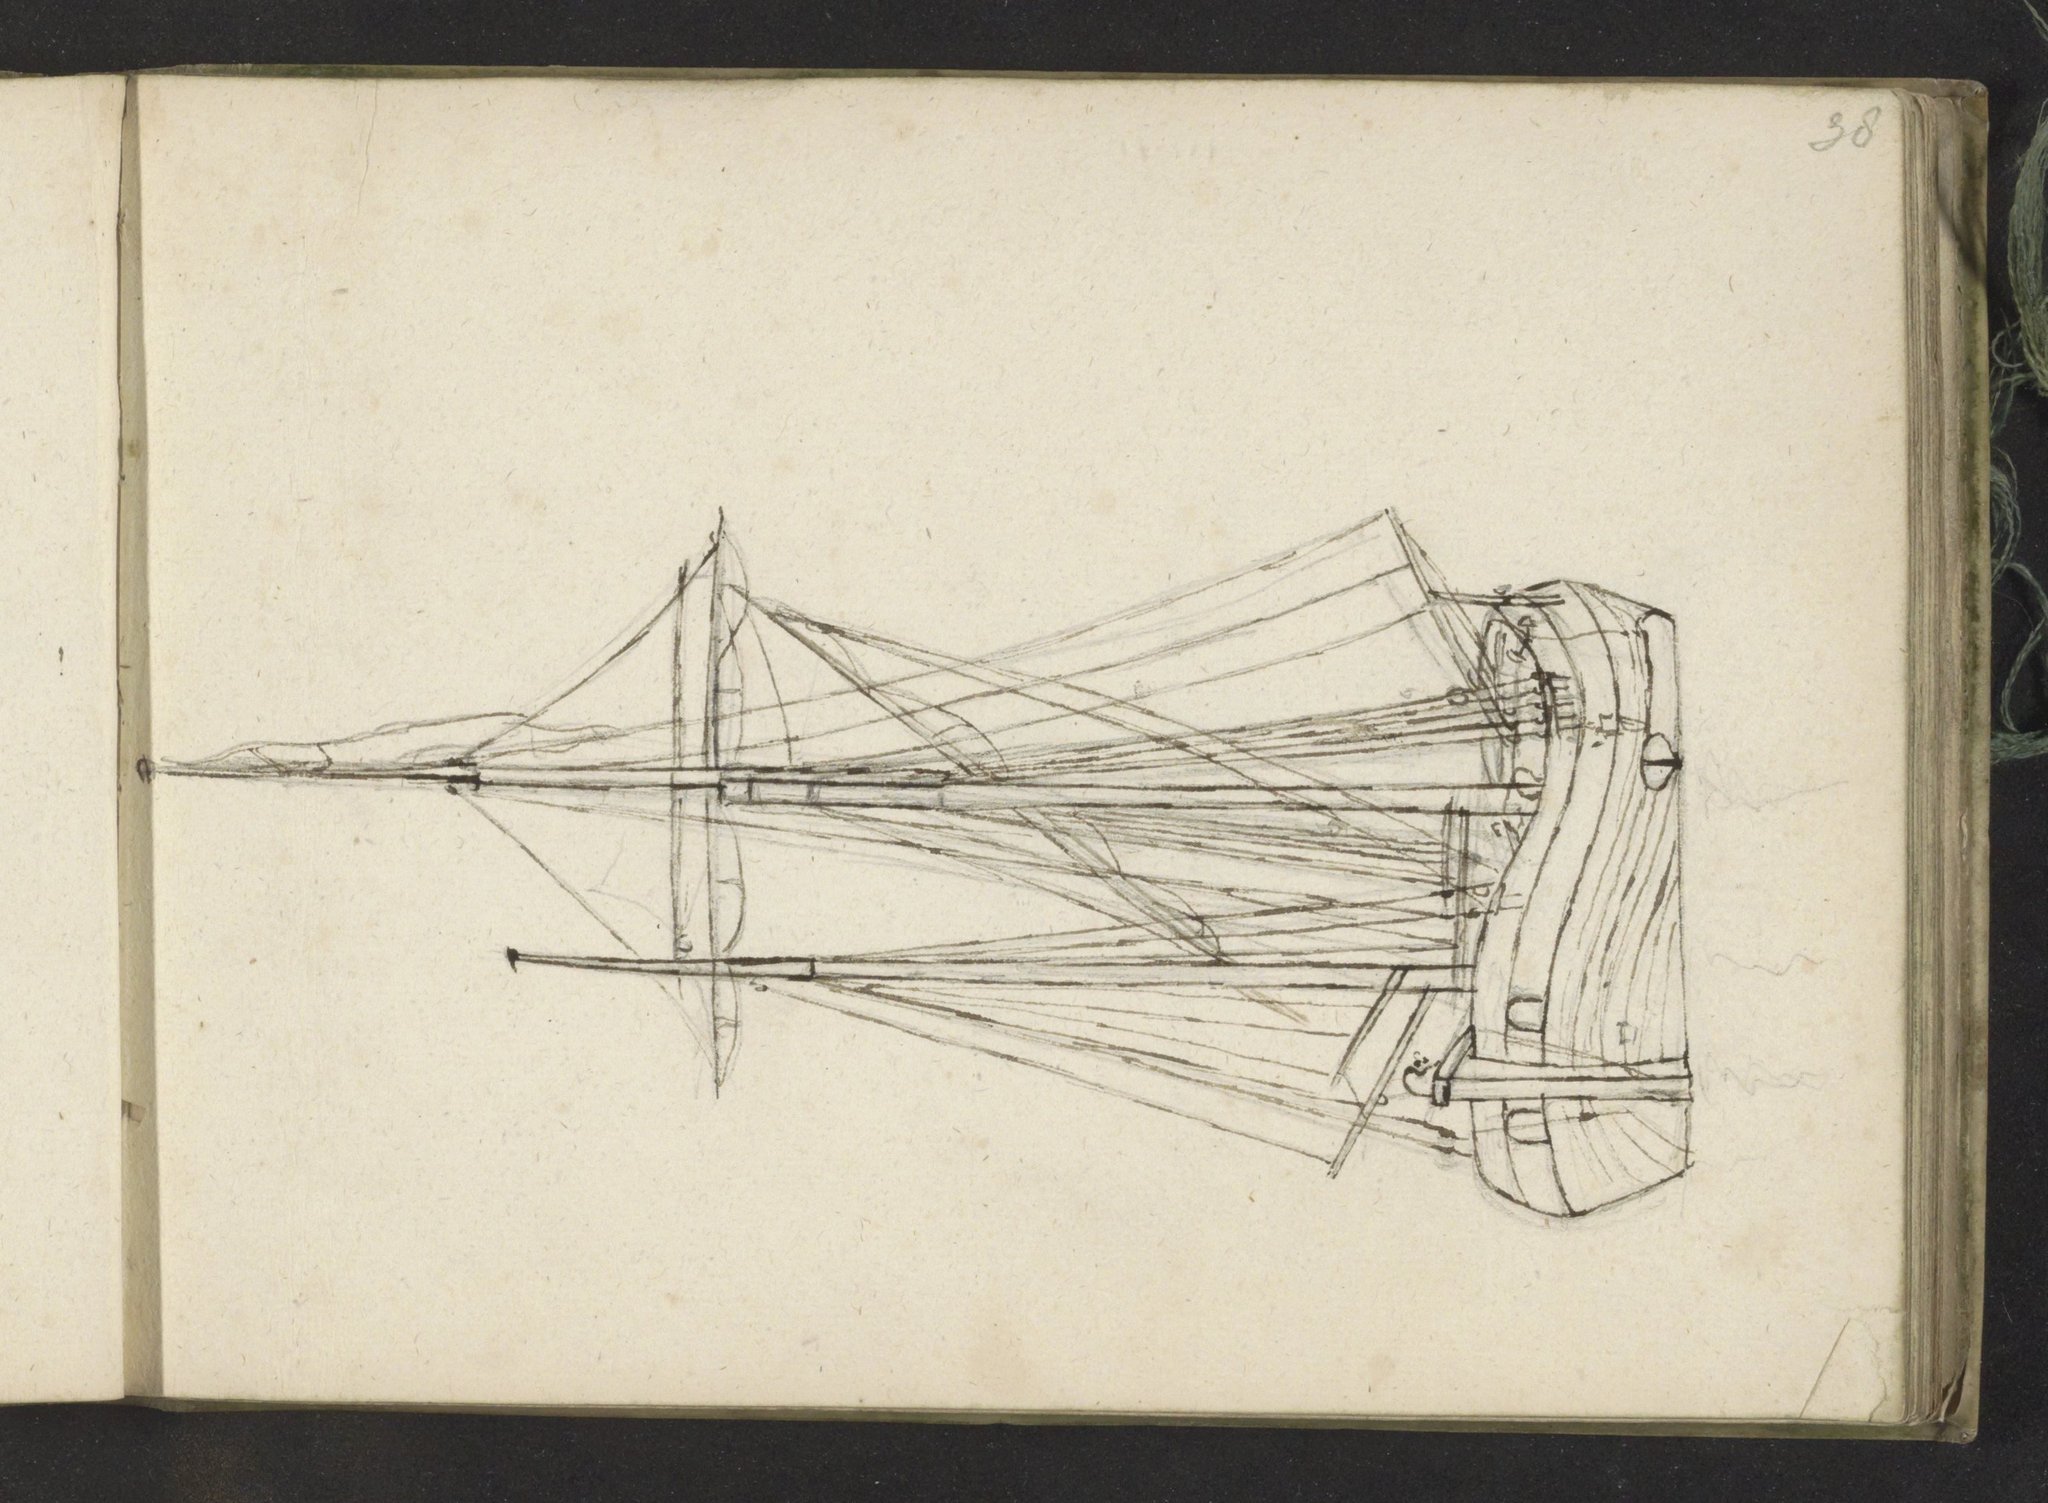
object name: sketchbook leaf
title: Zeilschip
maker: martinus schouman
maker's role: draughtsman, painter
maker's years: 1770-1848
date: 1780-1848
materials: ink, paper, pencil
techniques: pen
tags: sailing-ship, sailing-boat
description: Blad 38 recto uit een schetsboek met 53 bladen.